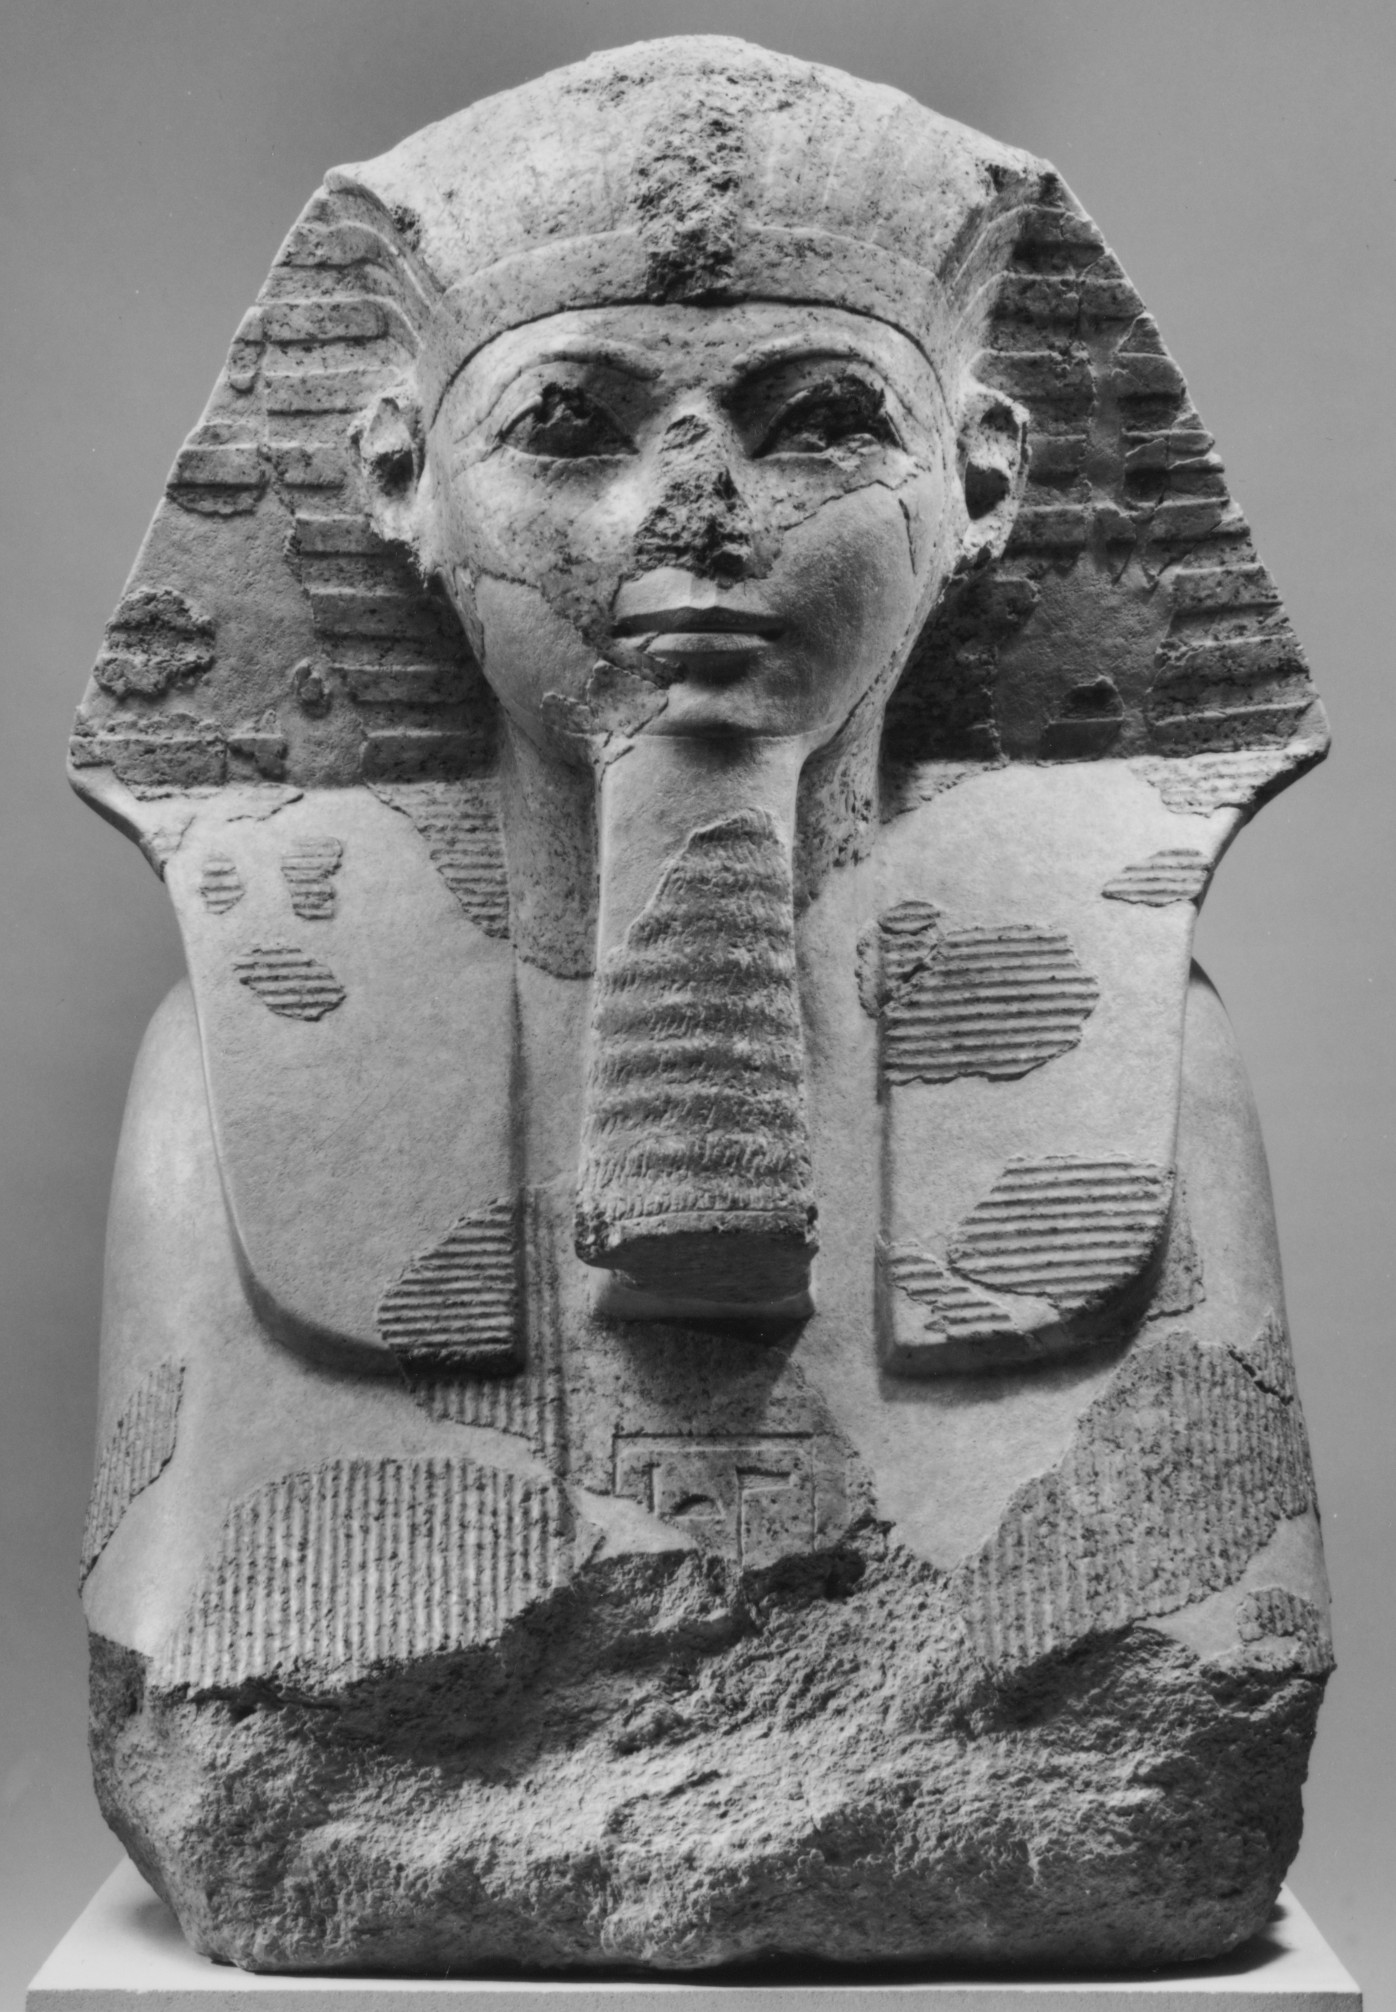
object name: sphinx, hatshepsut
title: Head and Shoulders of a Sphinx of Hatshepsut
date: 1479-1458 BCE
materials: granite, paint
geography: egypt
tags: sphinx